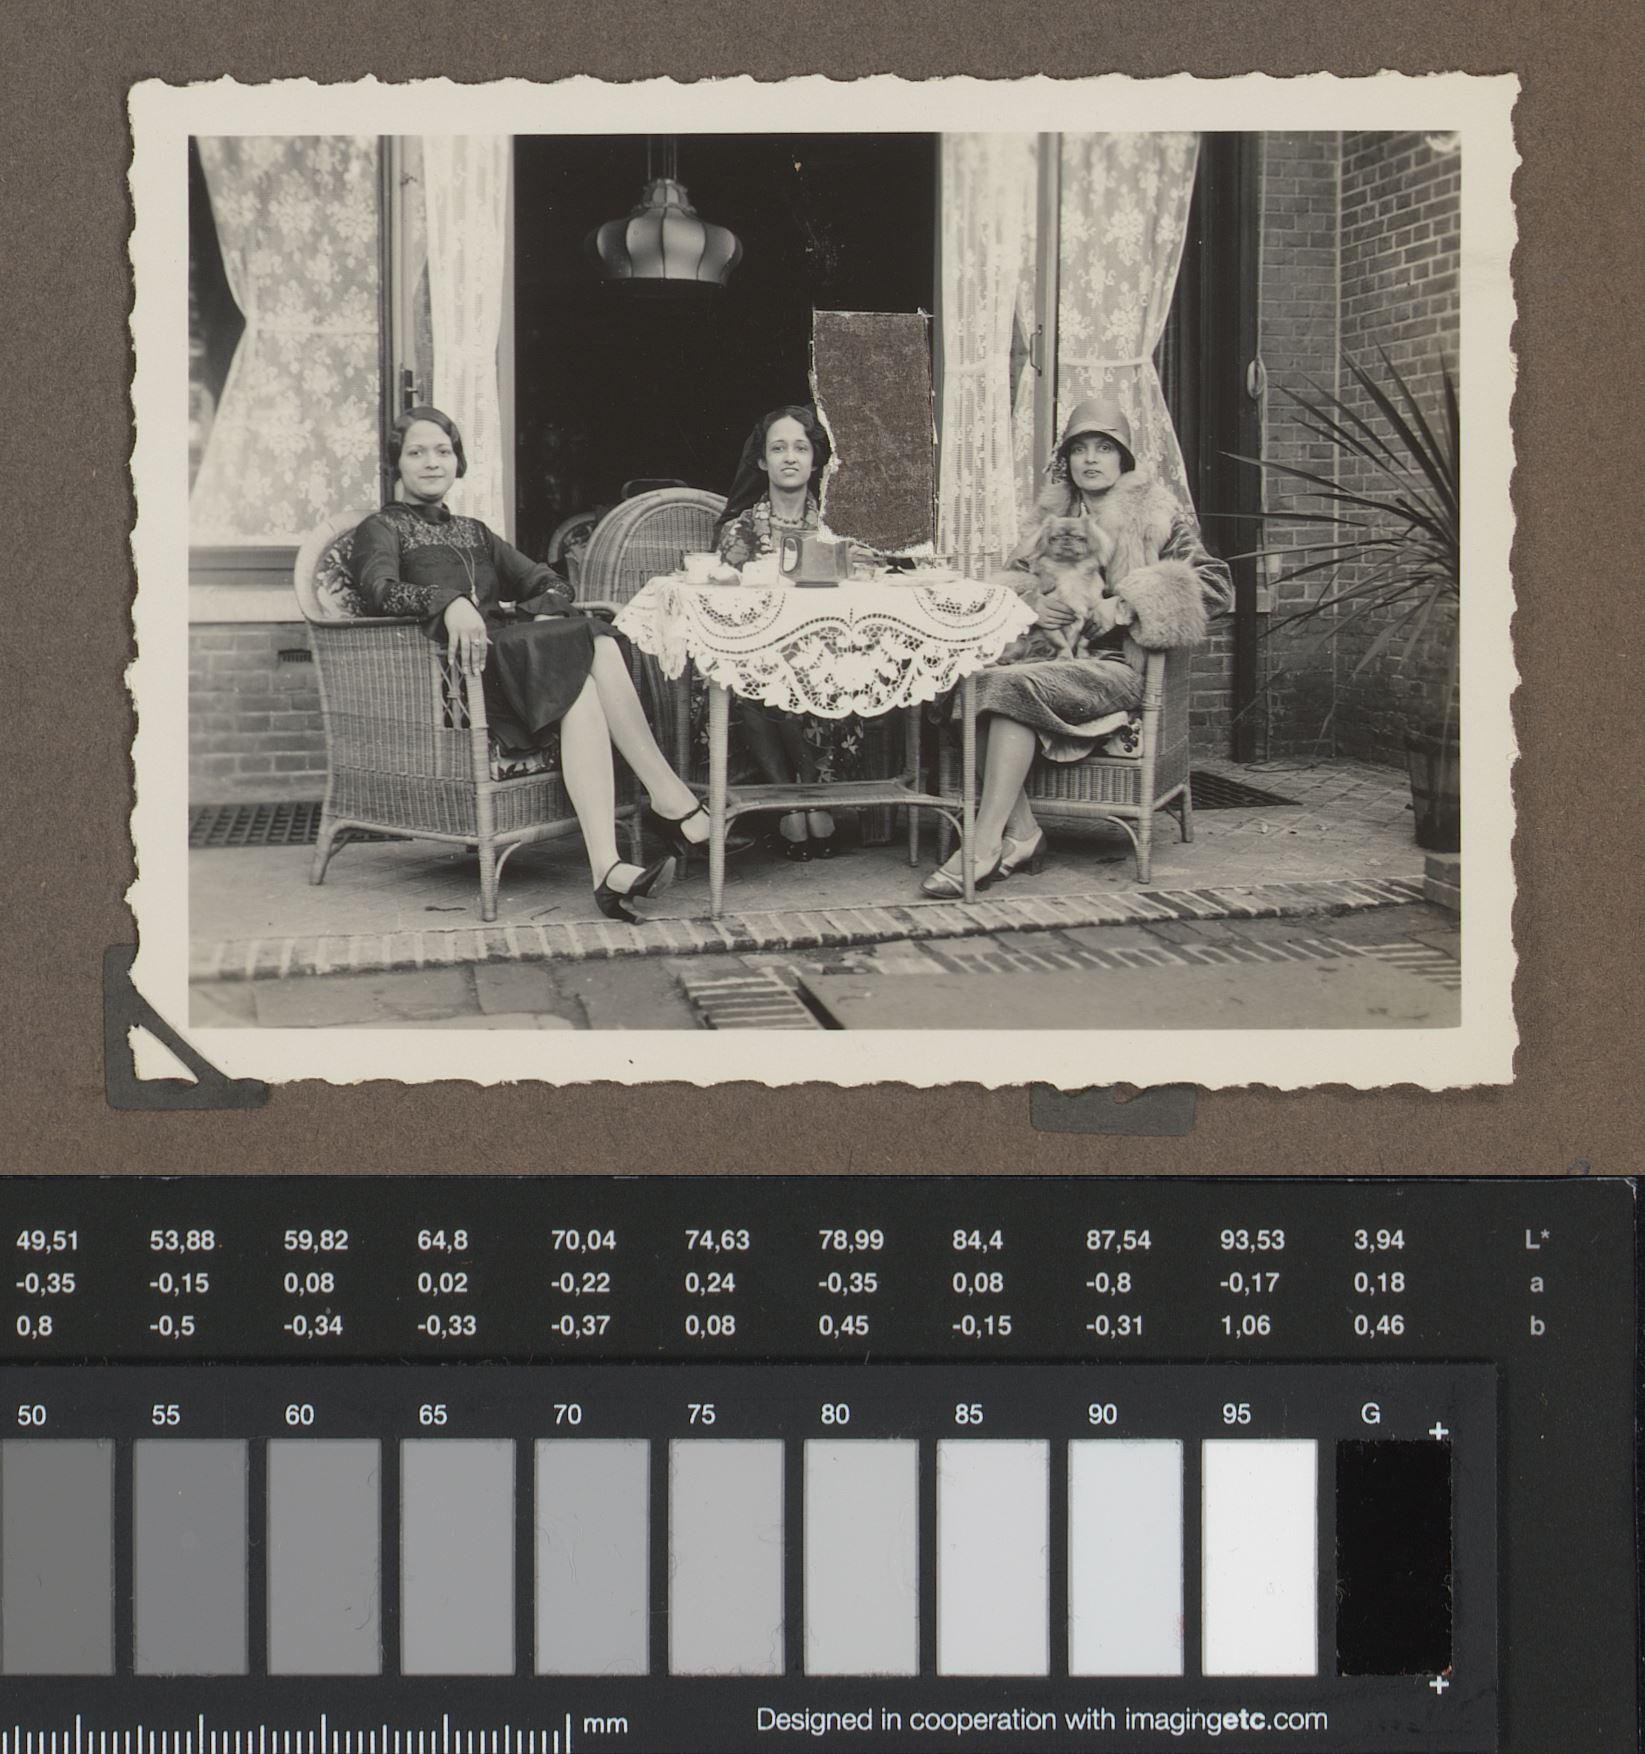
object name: photograph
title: Wilhelmina en Dootje van Zijll de Jong en Henriëtte Wassink zittend aan tafel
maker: Anonymous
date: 1930-1935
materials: paper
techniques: gelatin silver print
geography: netherlands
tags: batavia, the hague, henriëtte wassink, amsterdam, wilhelmina van zijll de jong, adult woman, mother and daughter(s) (family group), afternoon tea, netherlands